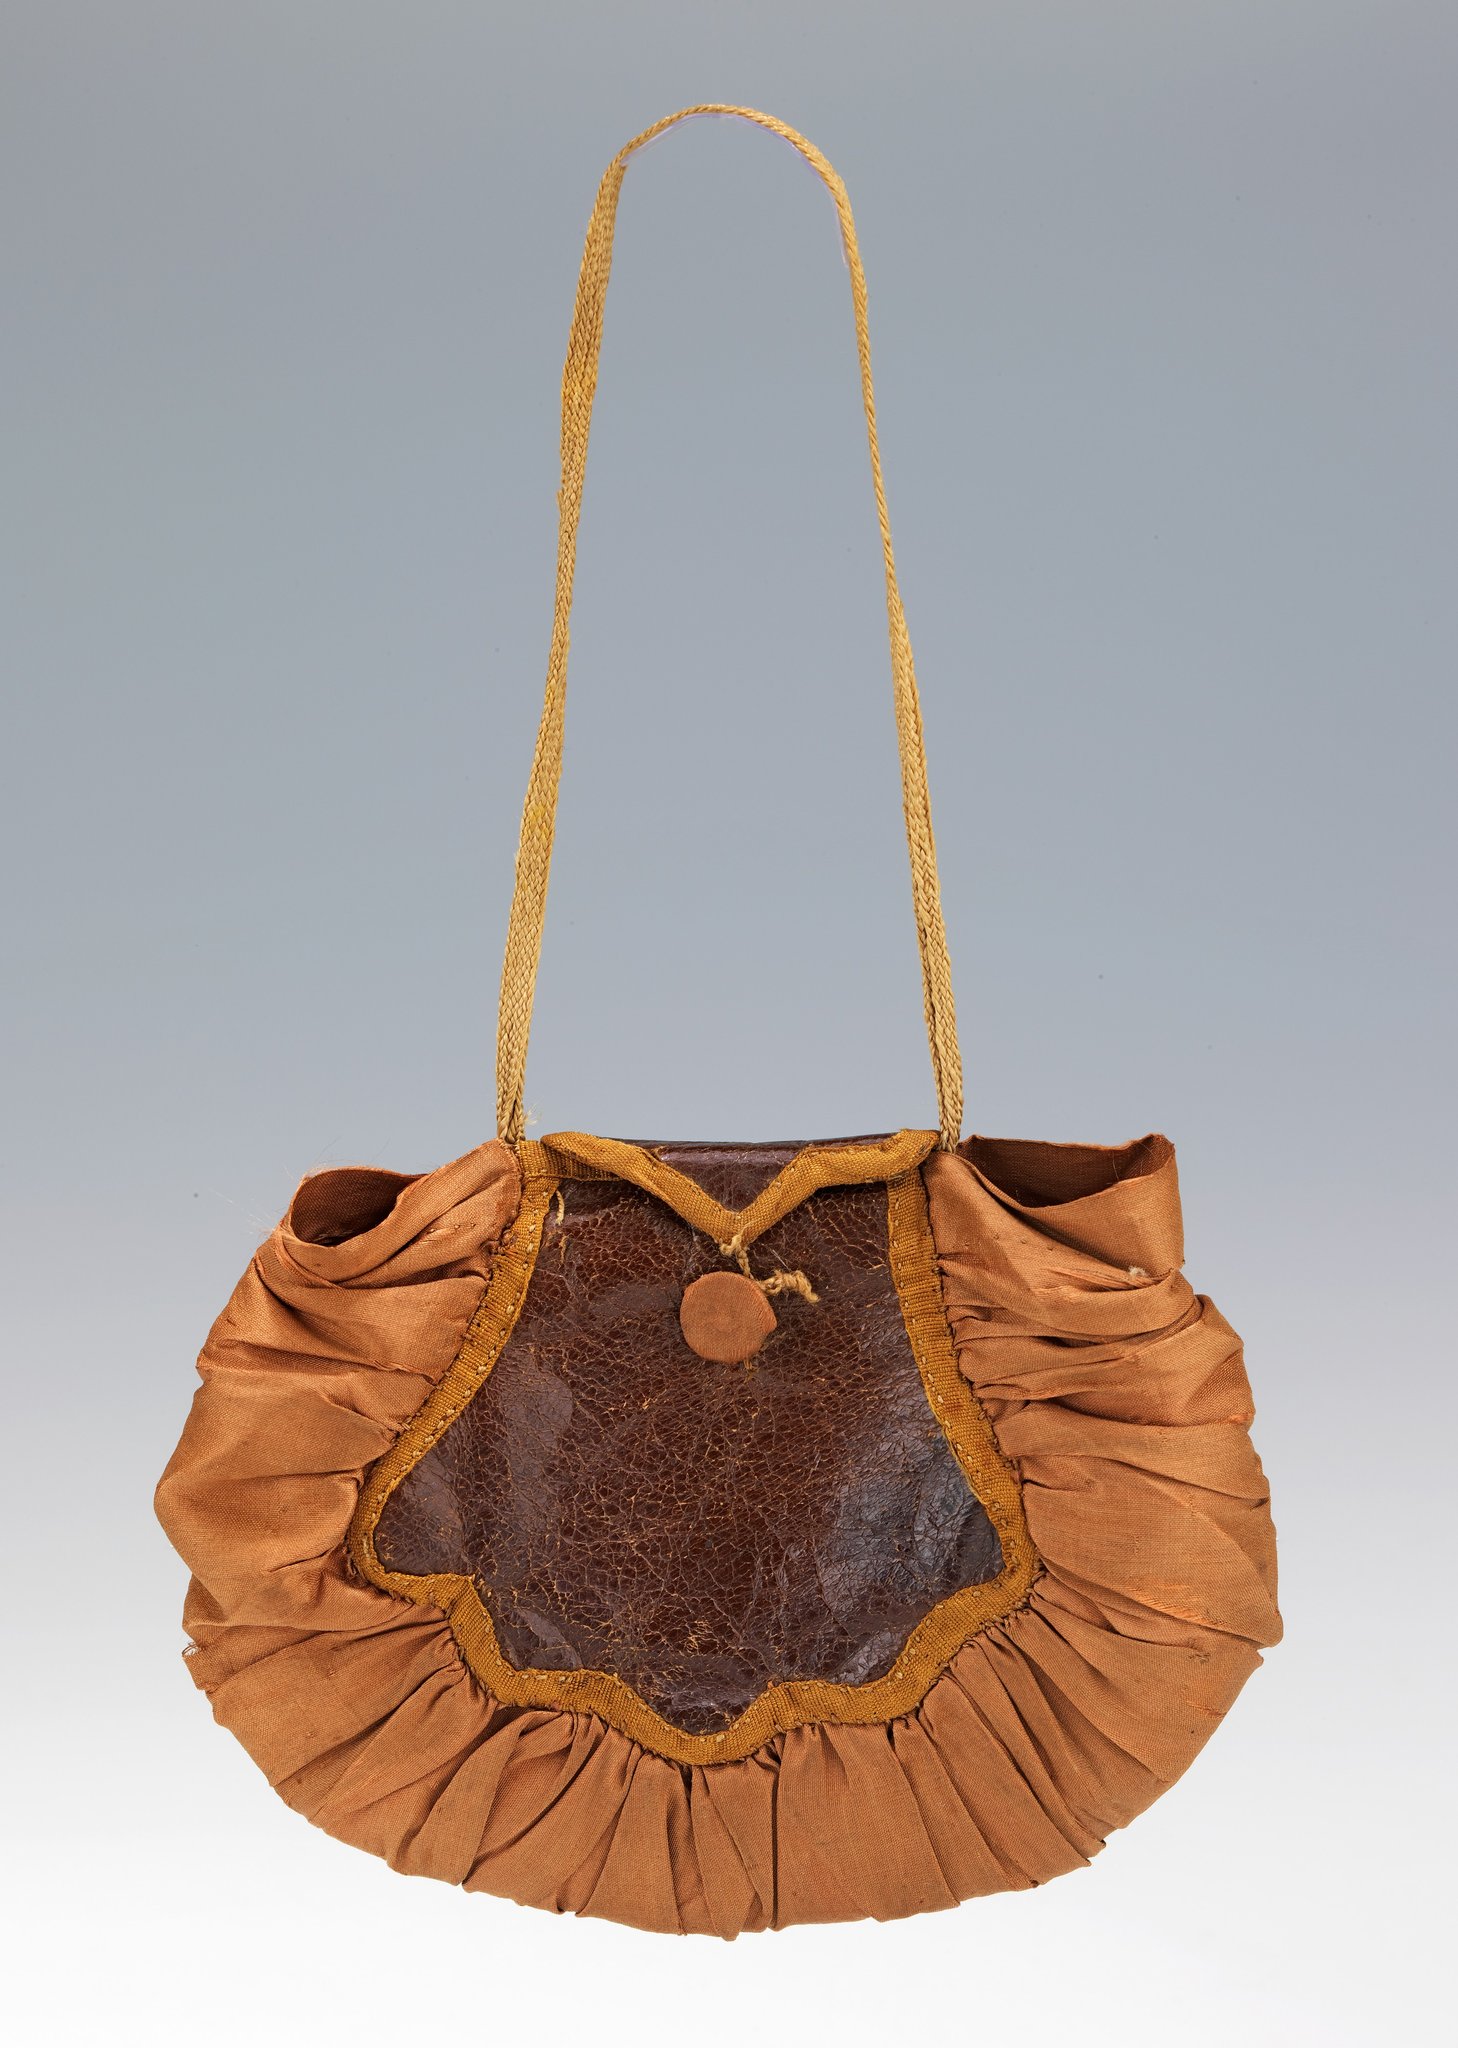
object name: bag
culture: american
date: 1840-1860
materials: leather, silk